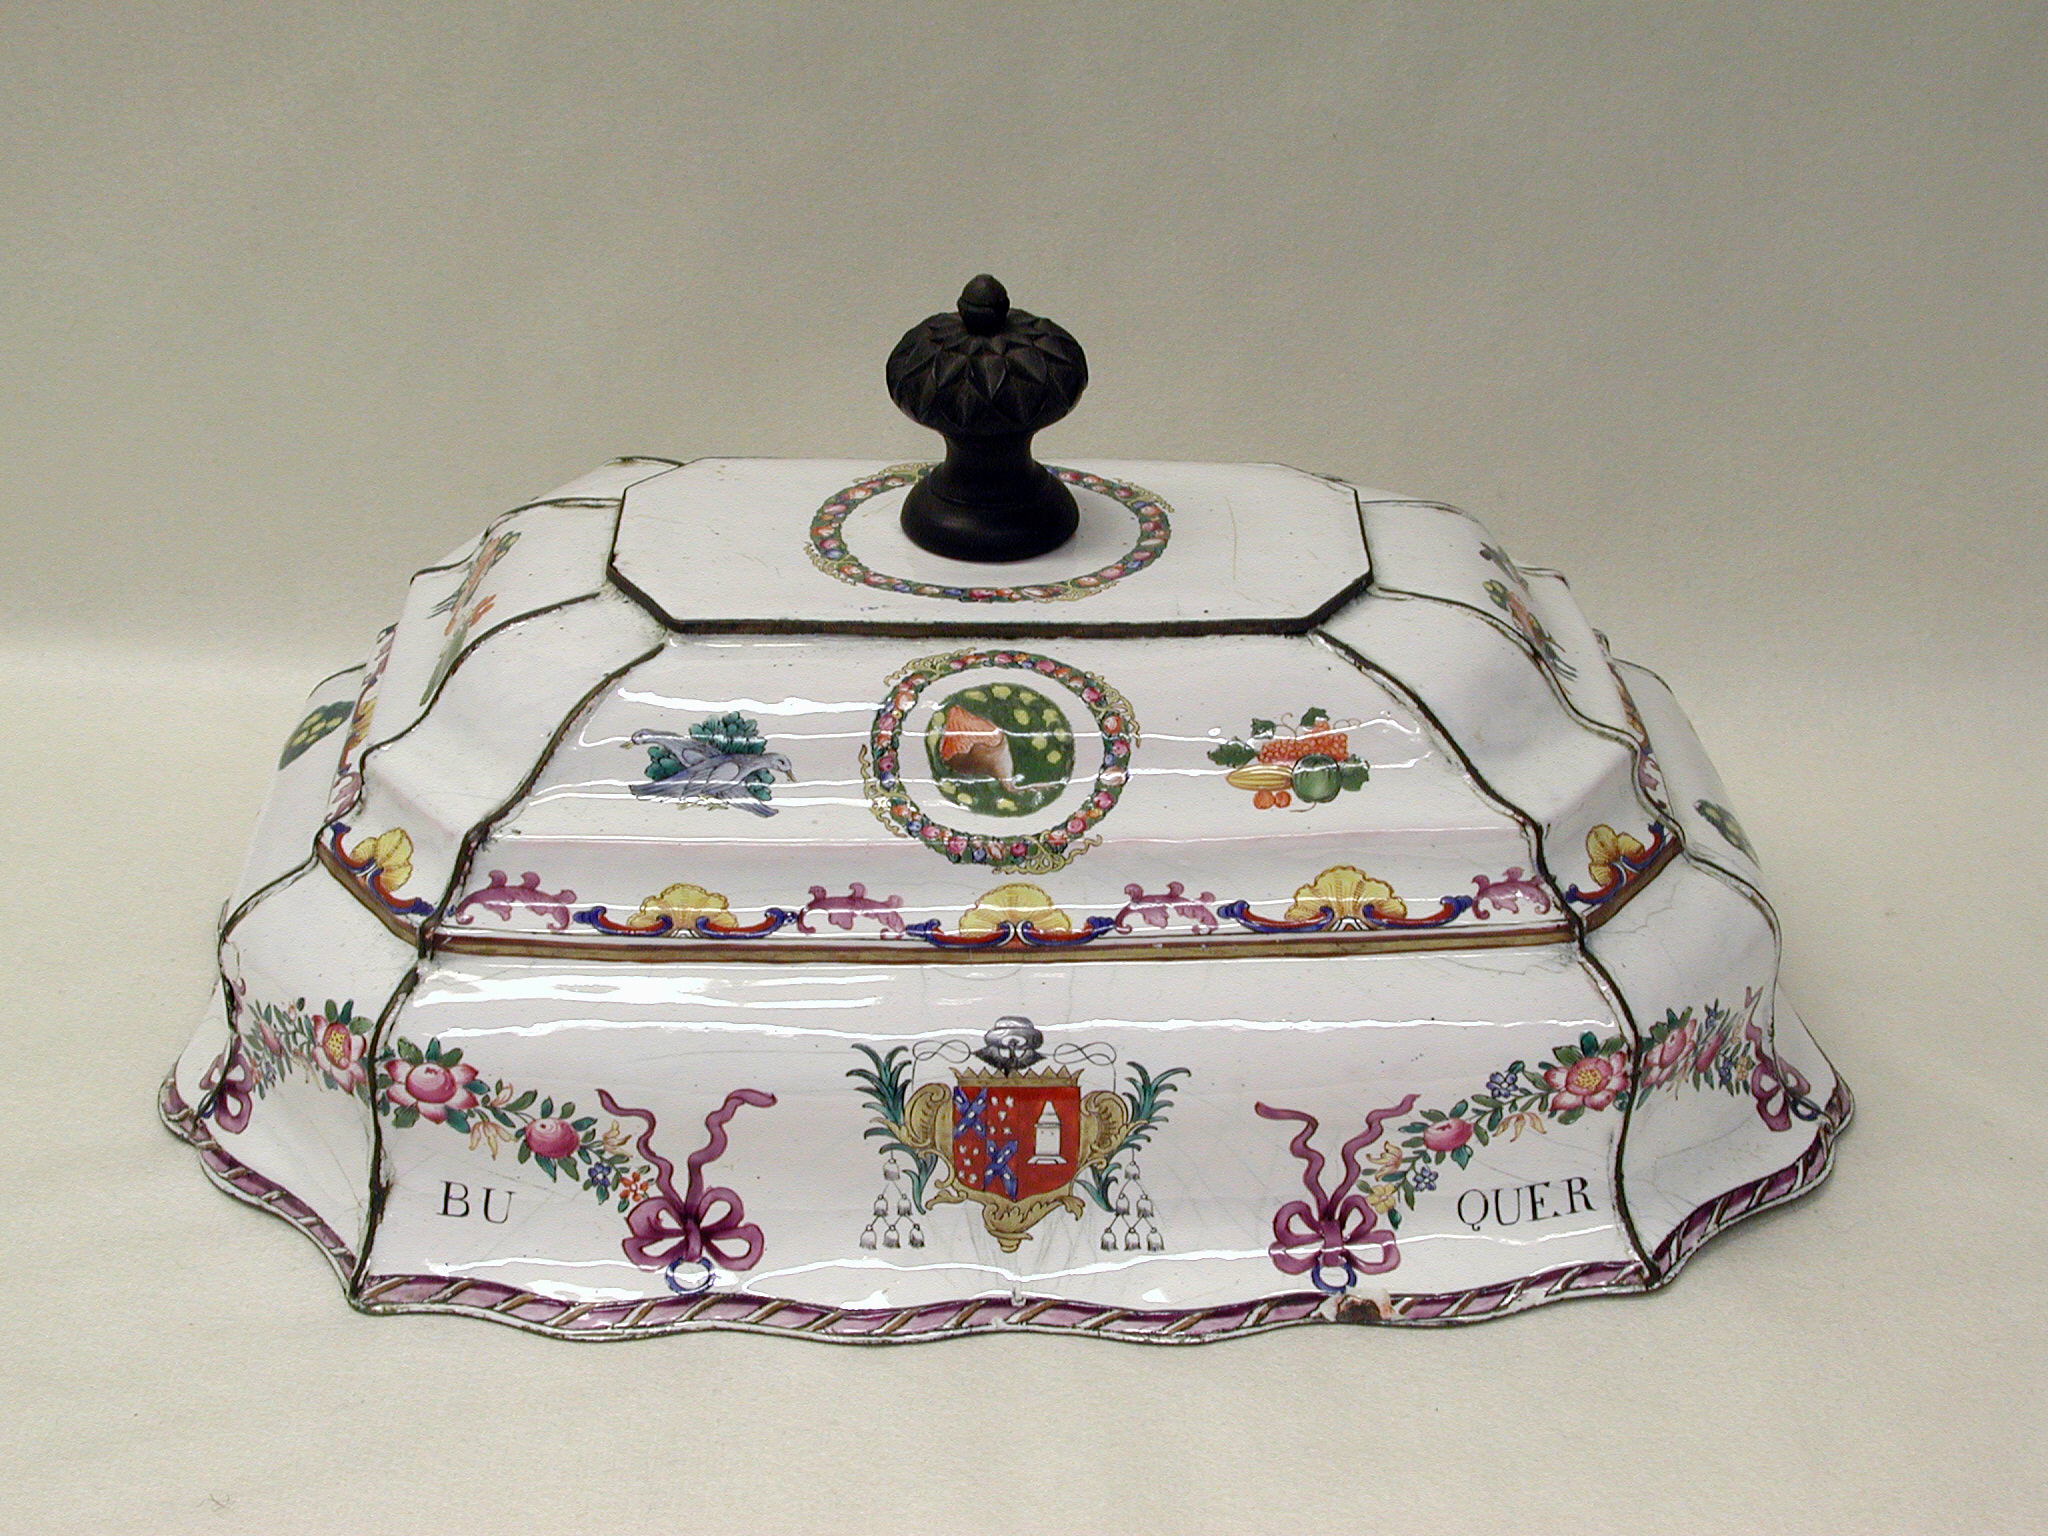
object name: cover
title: Cover (part of a service)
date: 1765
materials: copper, enamel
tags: birds,flowers,coat of arms